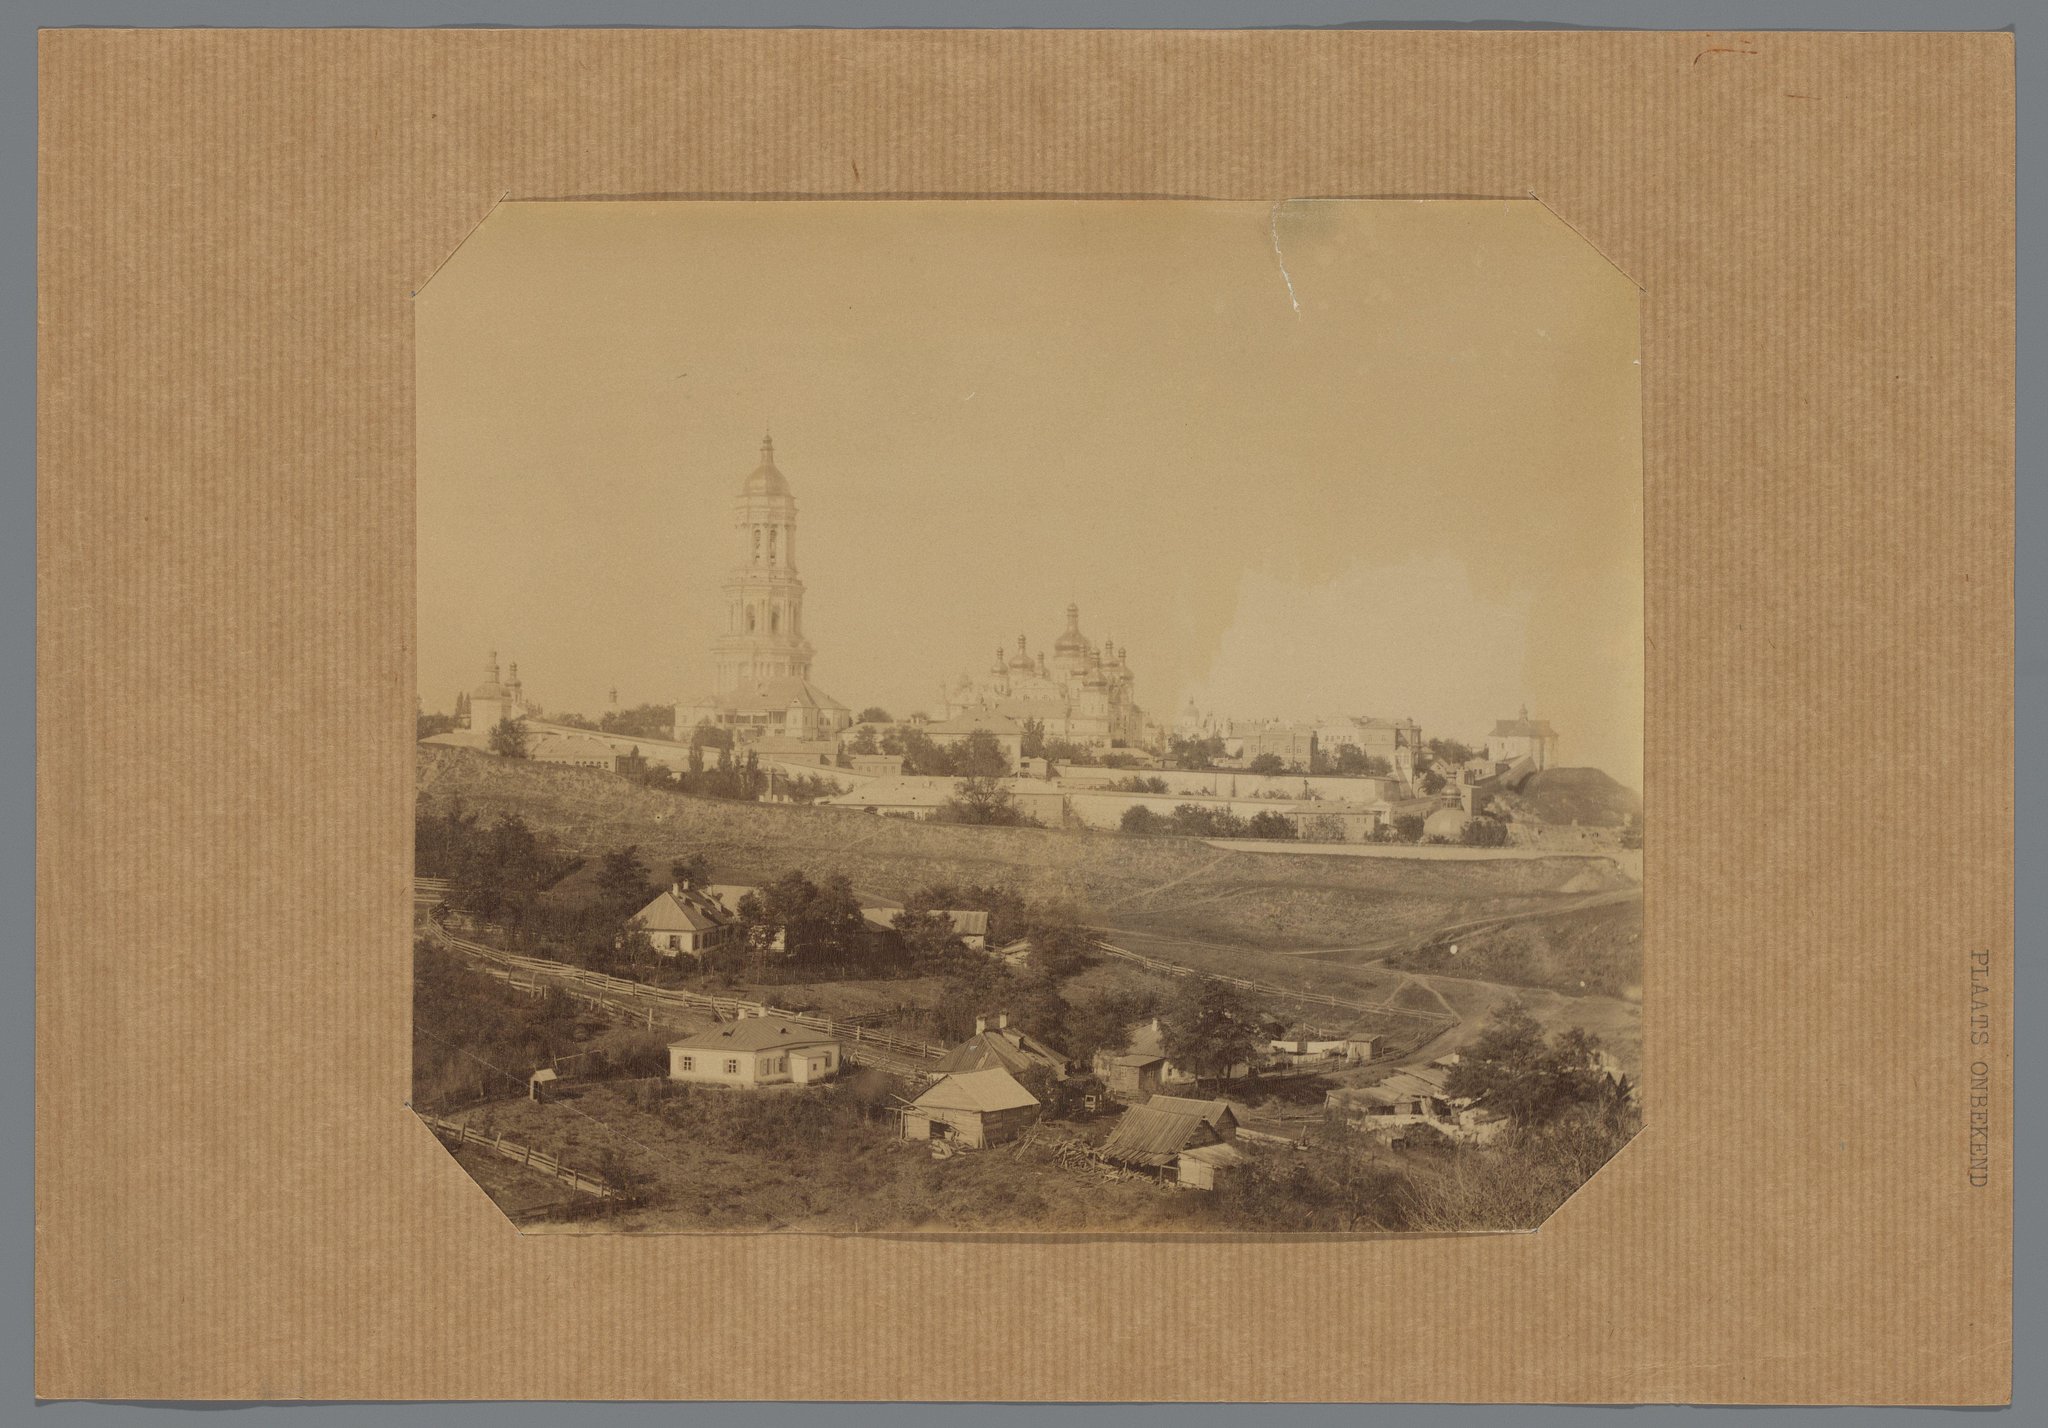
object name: photograph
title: Rusland: algemeen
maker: Anonymous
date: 1850-1900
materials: photographic support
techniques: albumen print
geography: russia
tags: russia